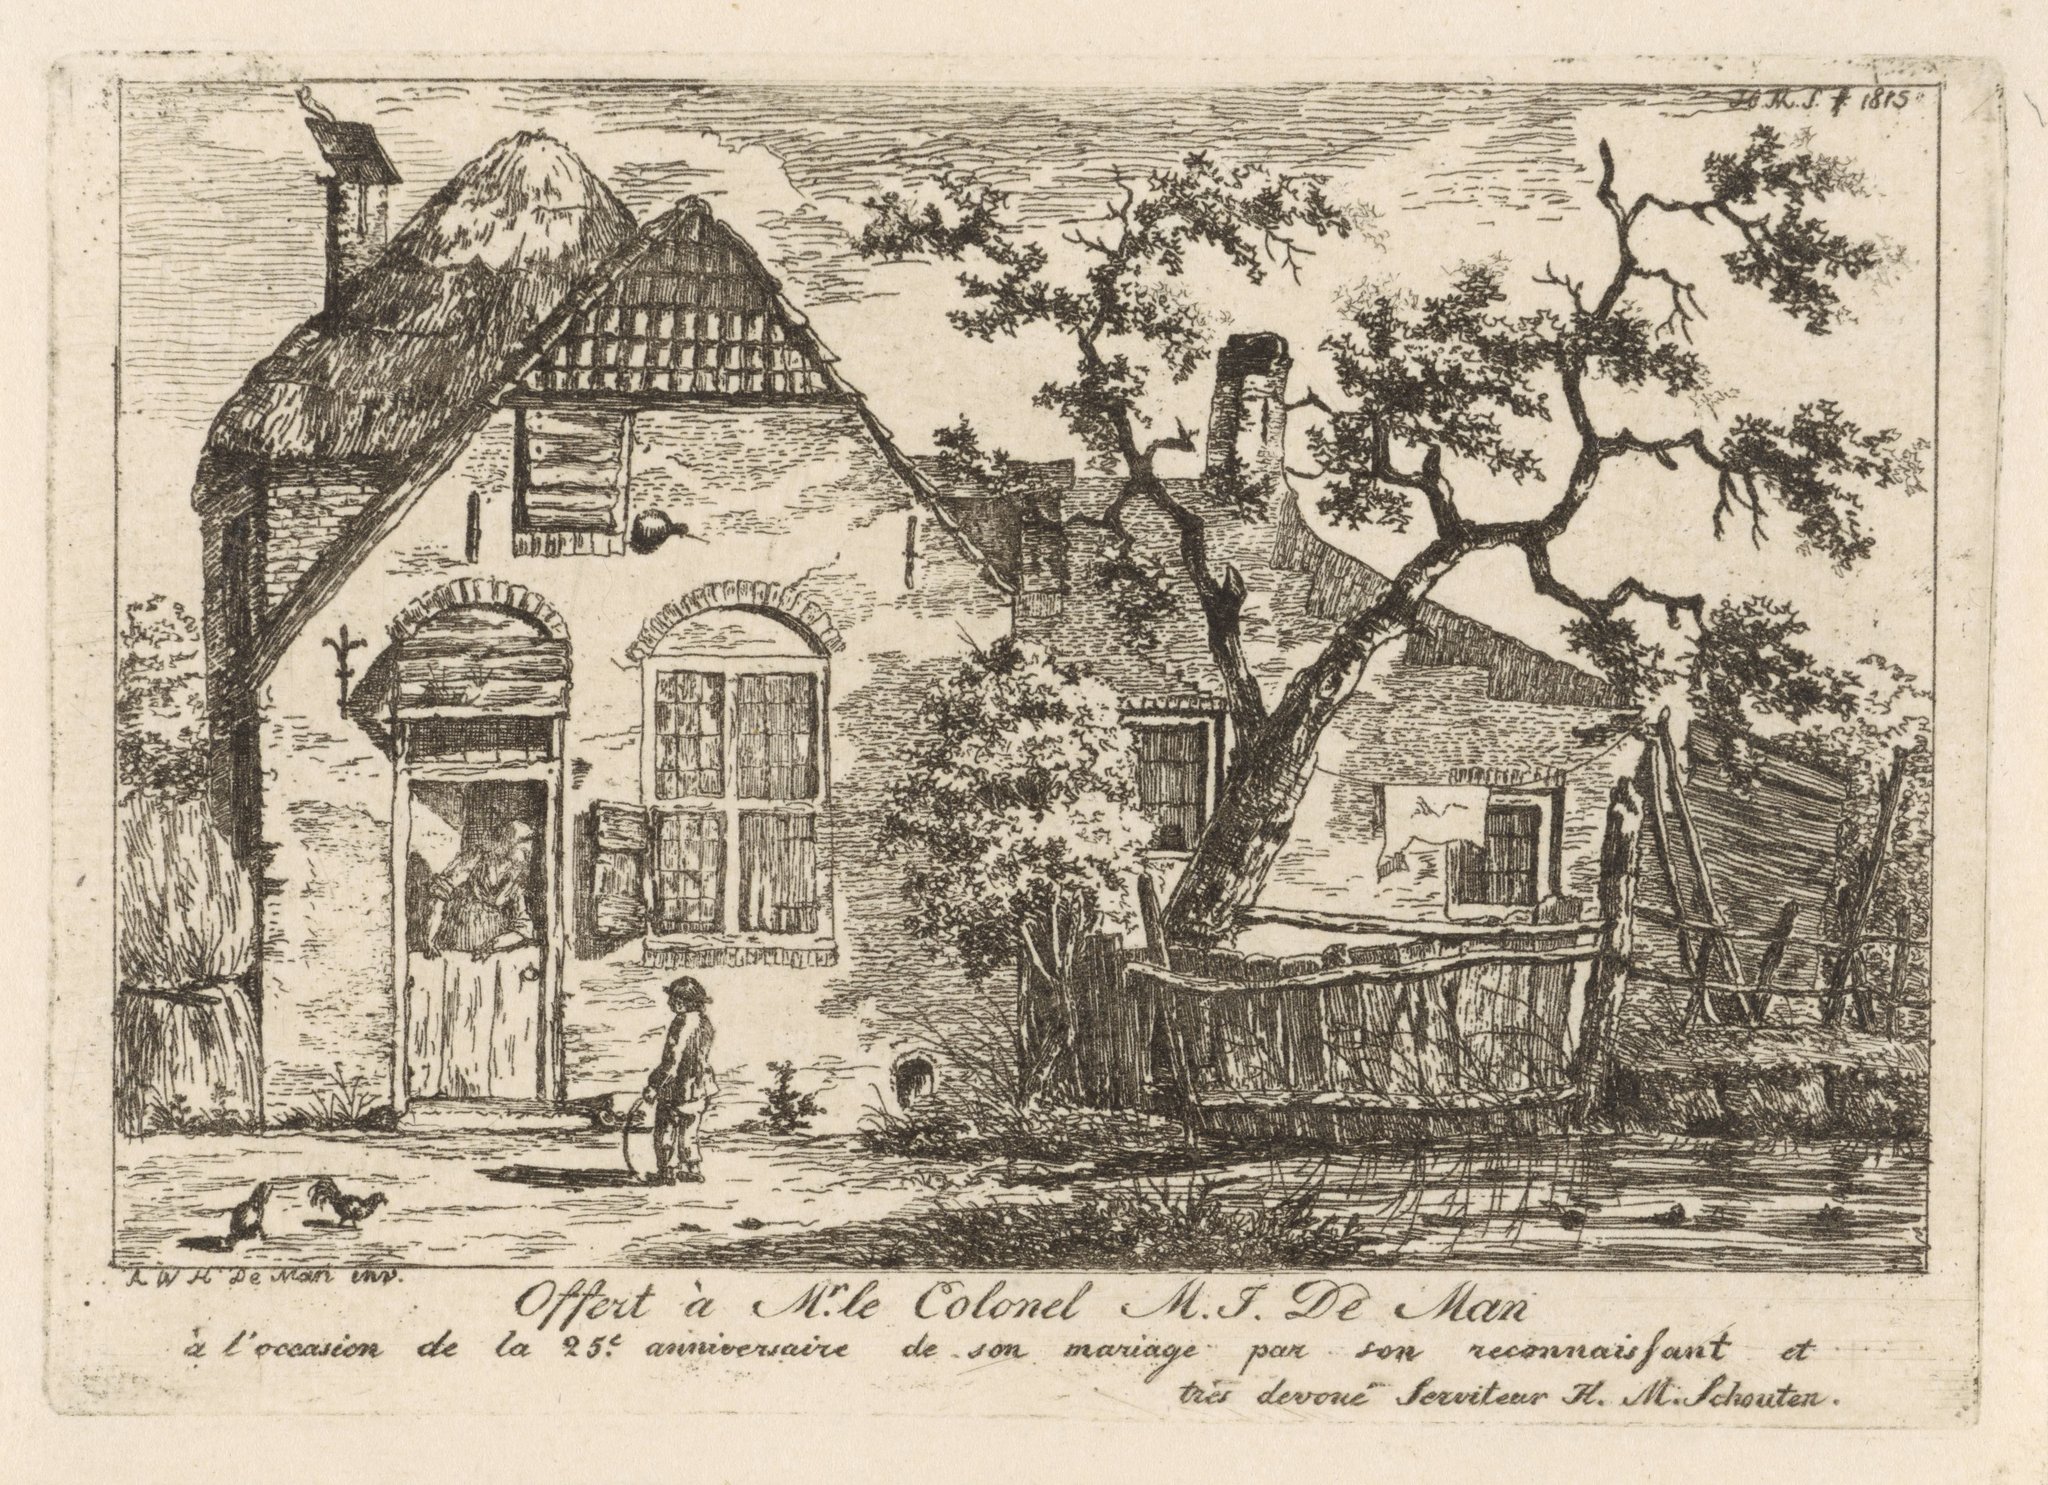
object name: print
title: Jongen met hoepel bij een boerderij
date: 1815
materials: paper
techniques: etching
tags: (bowling a) hoop, farm or solitary house in landscape, accessories and implements ~ laundering, e.g. clothes-peg, drying frame, (empty) washing line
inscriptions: collector's mark: Lugt 2228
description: Een jongen met een hoepel in de hand staat bij een boerderij. Een vrouw kijkt door de deur naar buiten. Aan een waslijn hangt was te drogen. Onder de prent een opdracht in het Frans.